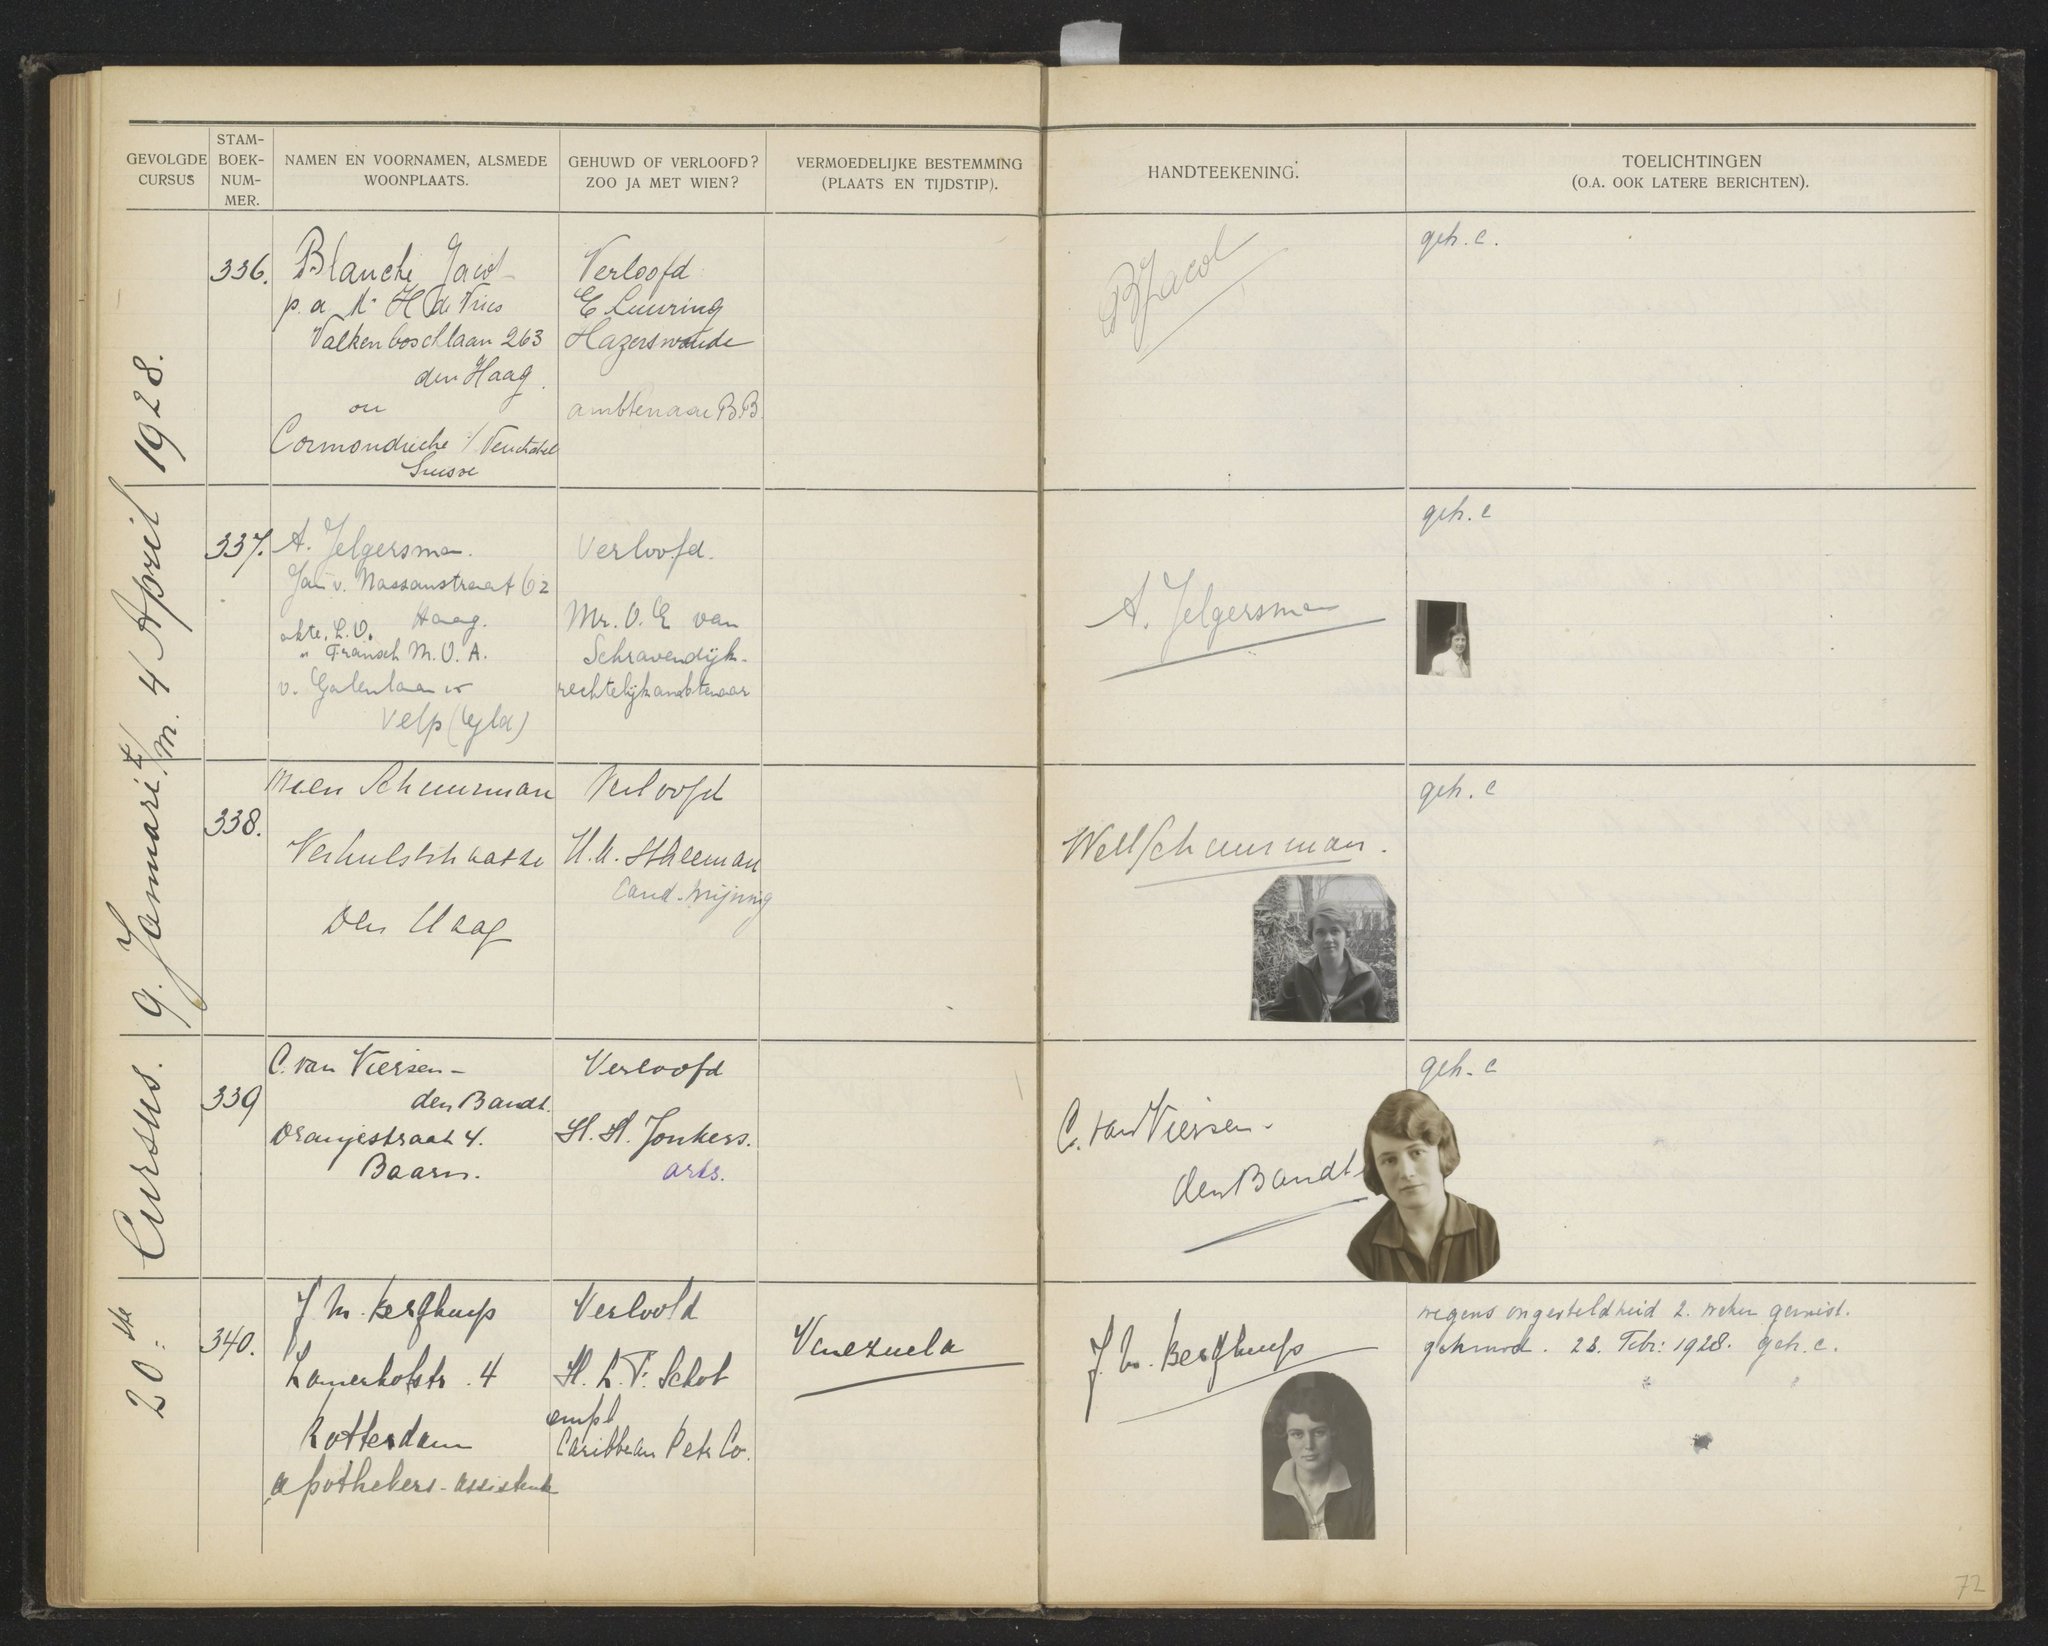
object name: album leaf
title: Blad 72 uit Stamboek van de leerlingen der Koloniale School voor Meisjes en Vrouwen te 's-Gravenhage deel I (1921-1929)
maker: Anonymous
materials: paper, photographic support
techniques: photography, printing, writing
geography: the hague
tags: further education (+ pupil), further education, the hague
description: Twee pagina's met gegevens van de deelnemers aan de 20e driemaandelijkse cursus van 9 januari tot en met 4 april 1928, stamboeknummers 336 tot en met 340. Onderdeel van Stamboek van de leerlingen der Koloniale School voor Meisjes en Vrouwen te 's-Gravenhage deel I (1921-1929).